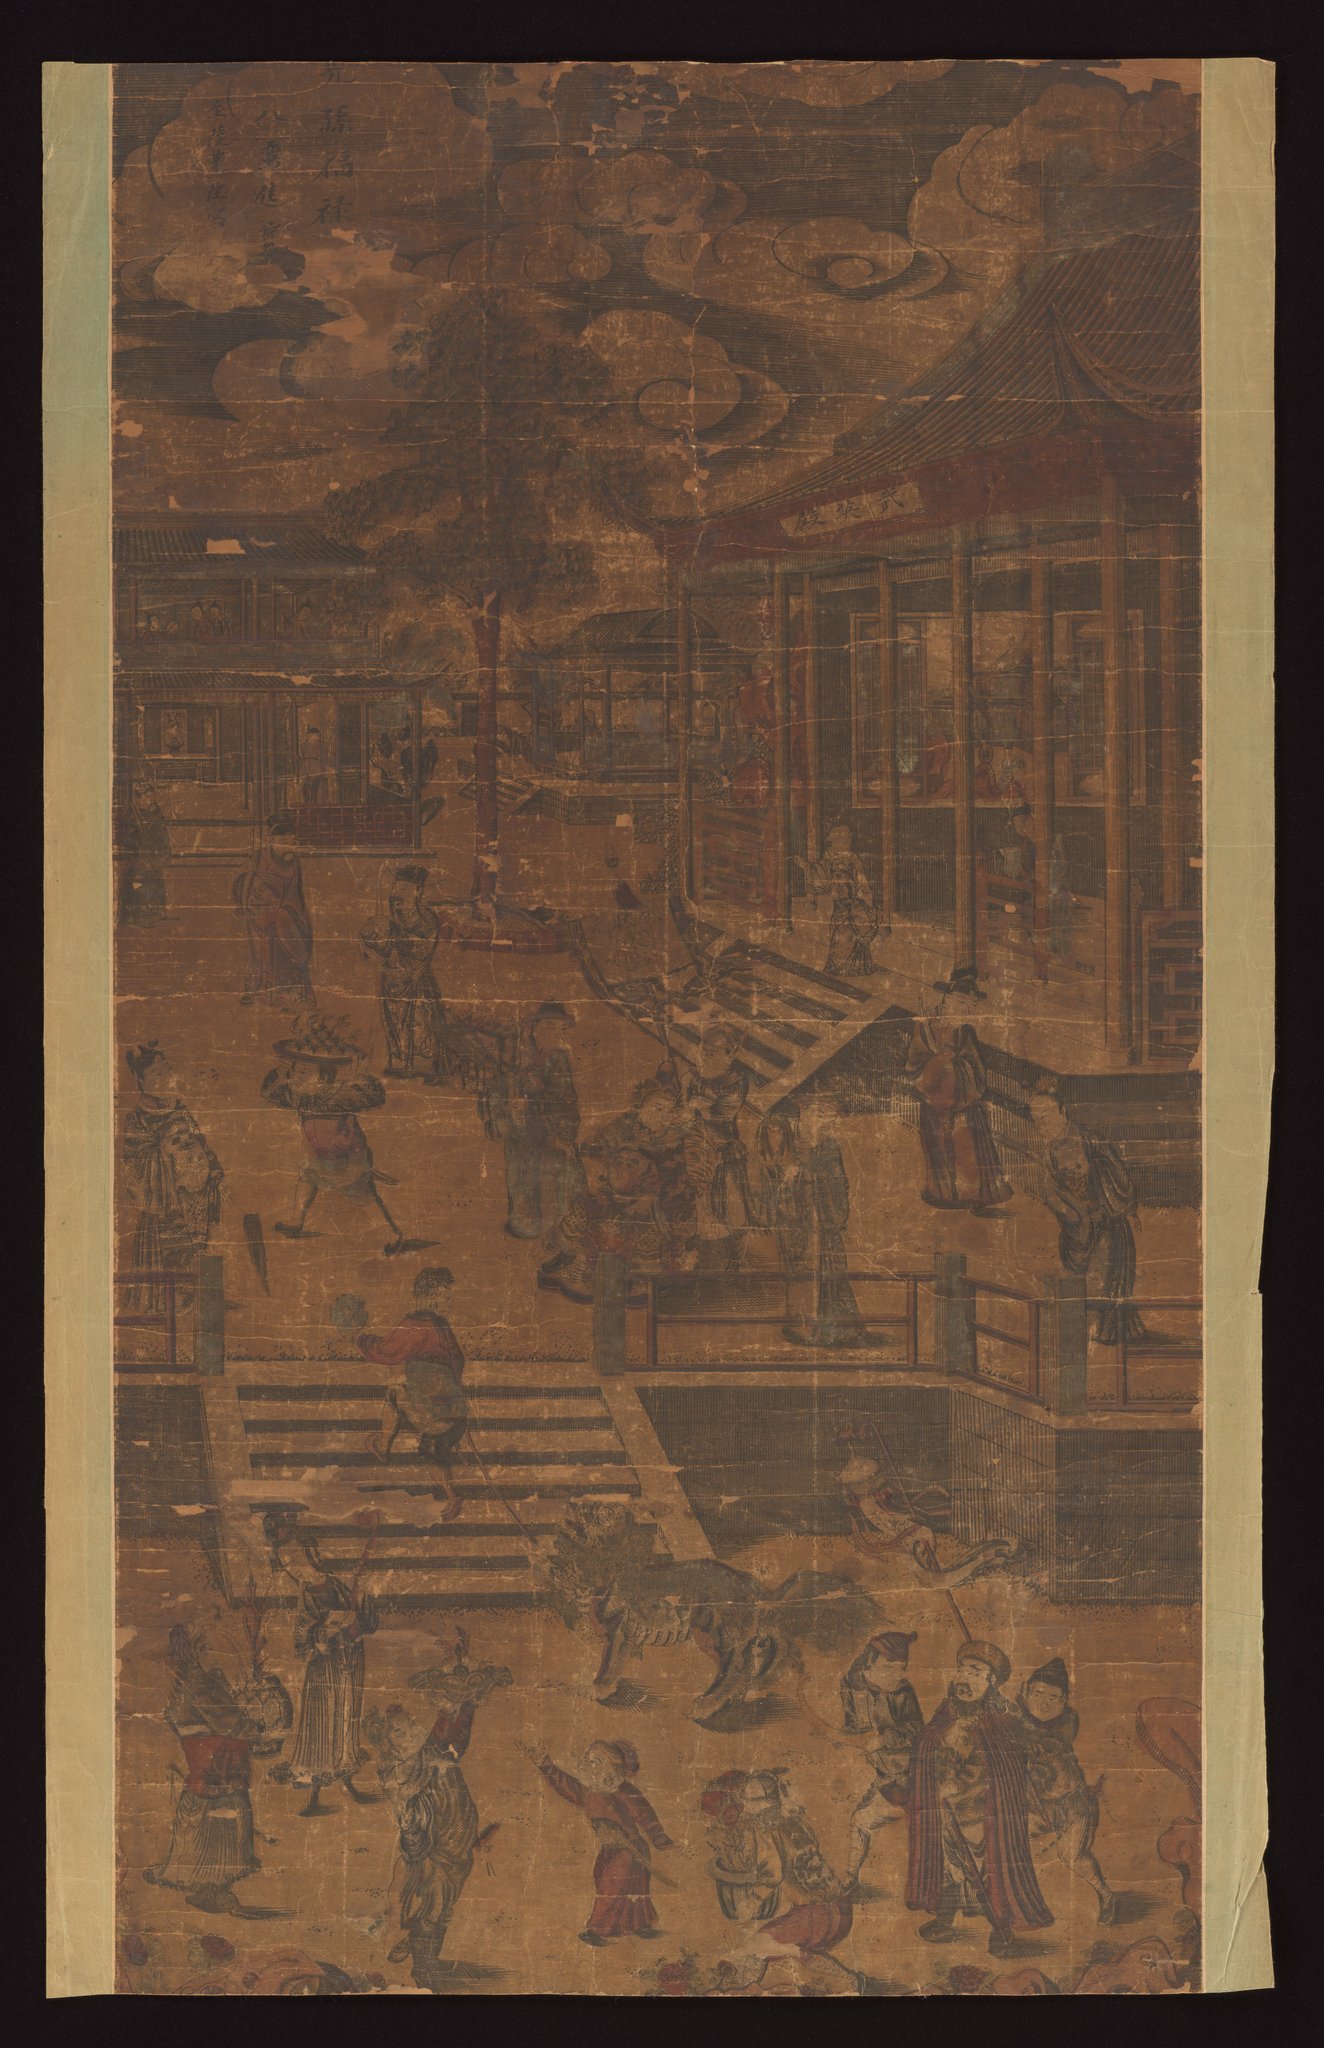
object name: print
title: Children and Grandchildren Bring Fortune and Prosperity. The Eight Barbarians Bring Tribute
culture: chinese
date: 1736-1795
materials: ink, paper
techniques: hand coloring, woodblock print